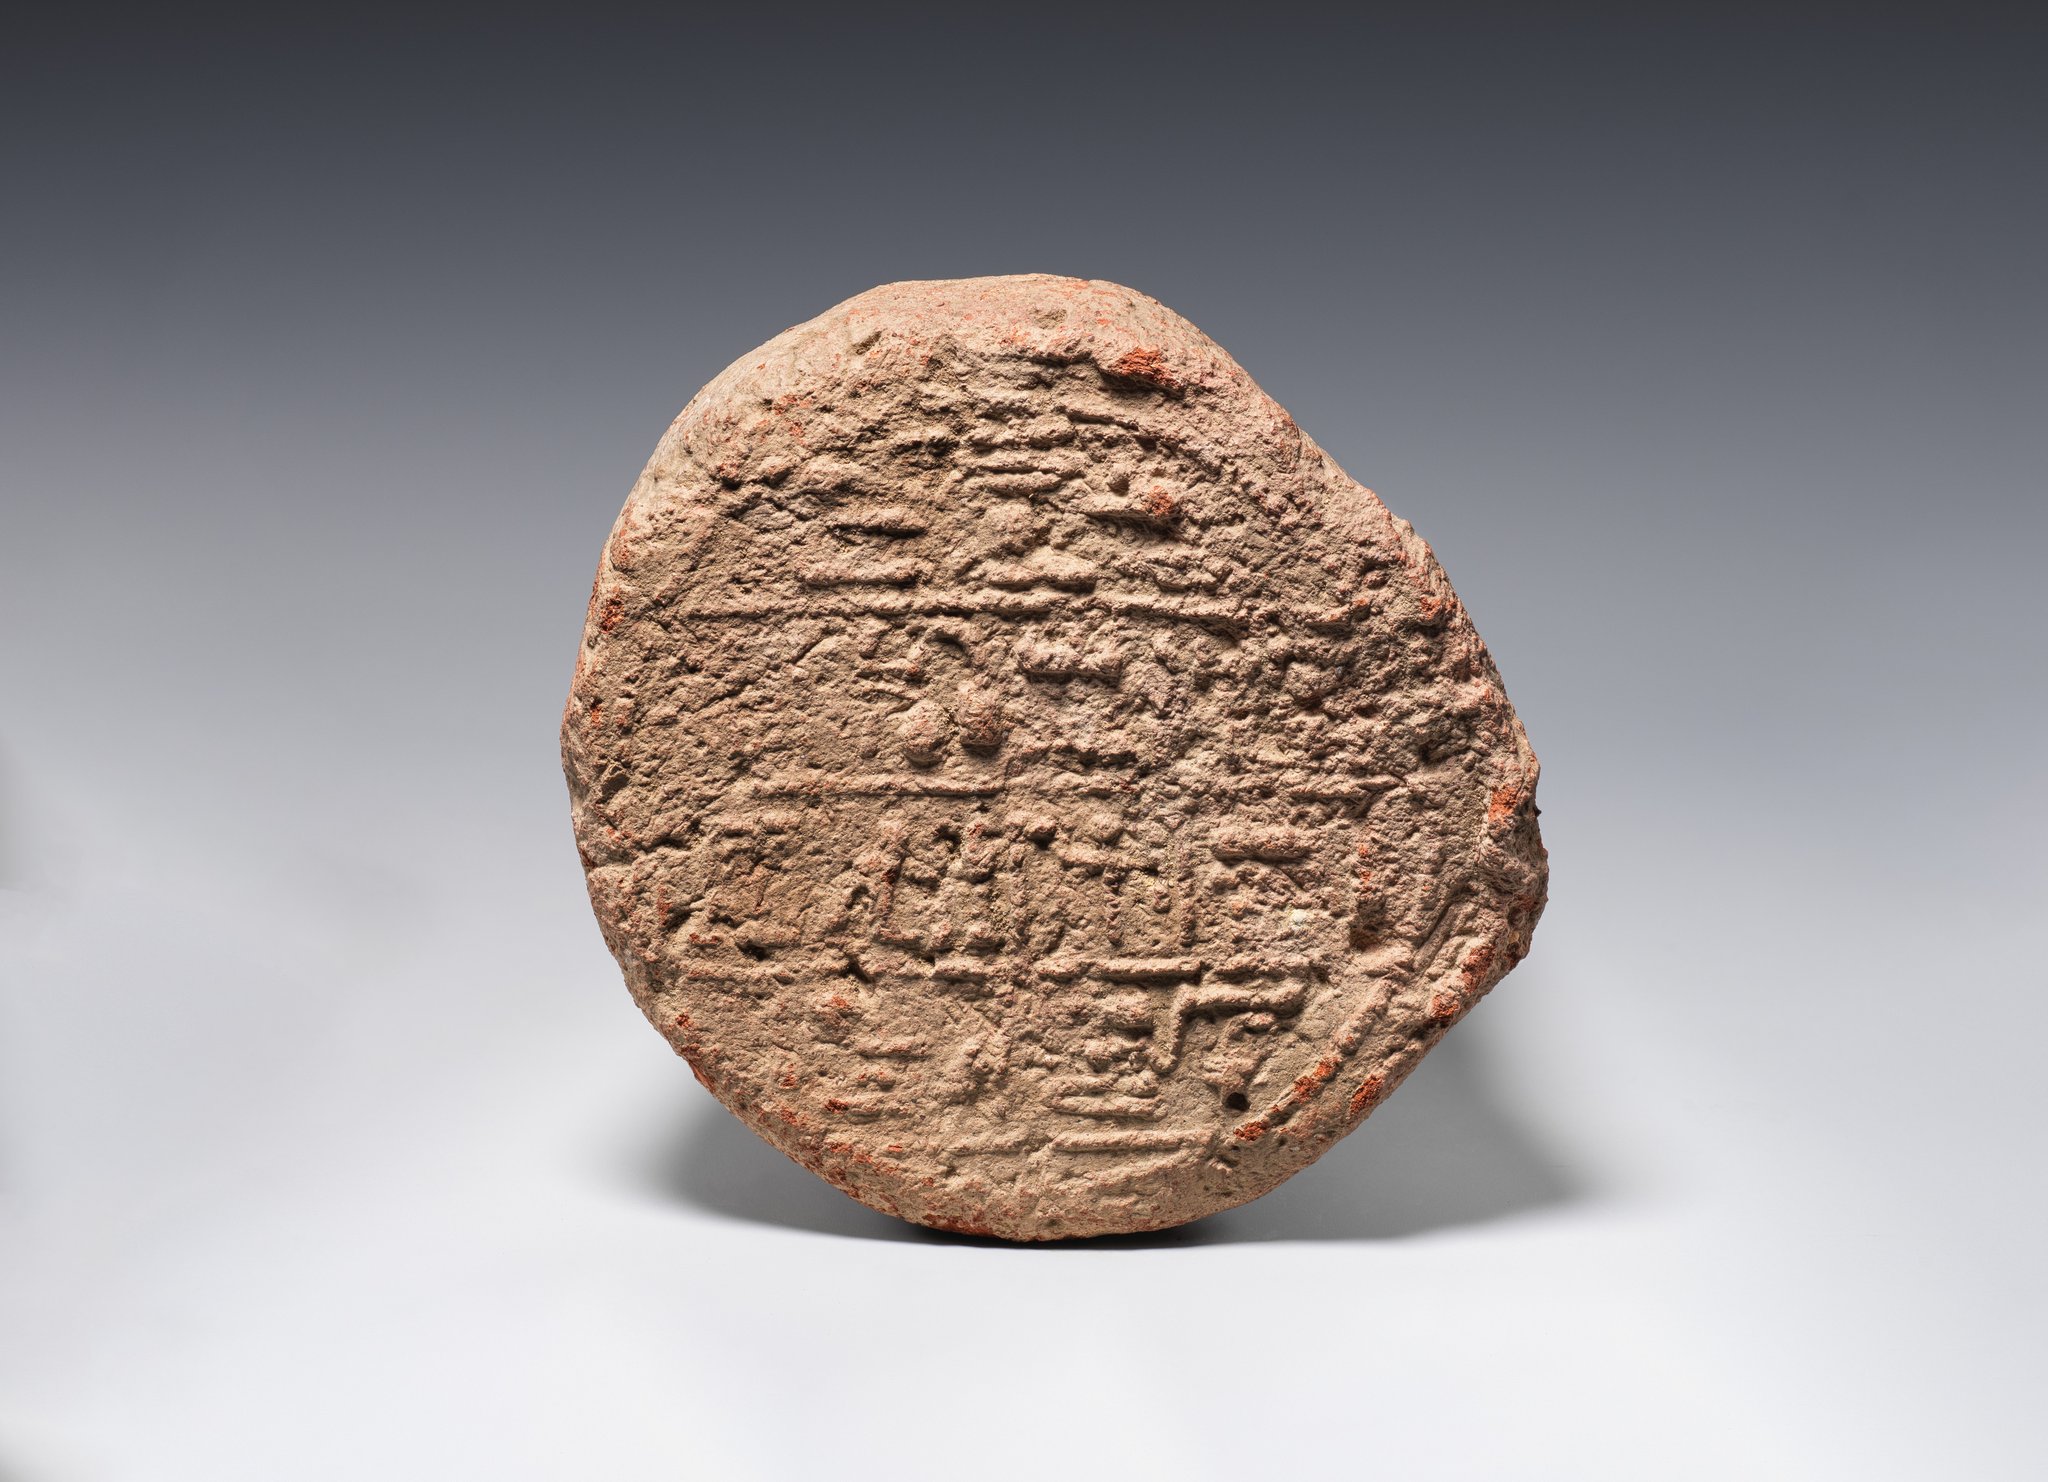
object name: cone, davy 461, montuemhat, fourth prophet, amun, scribe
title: Funerary Cone of the Fourth Prophet of Amun Montuemhat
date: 712-525 BCE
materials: pottery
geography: egypt